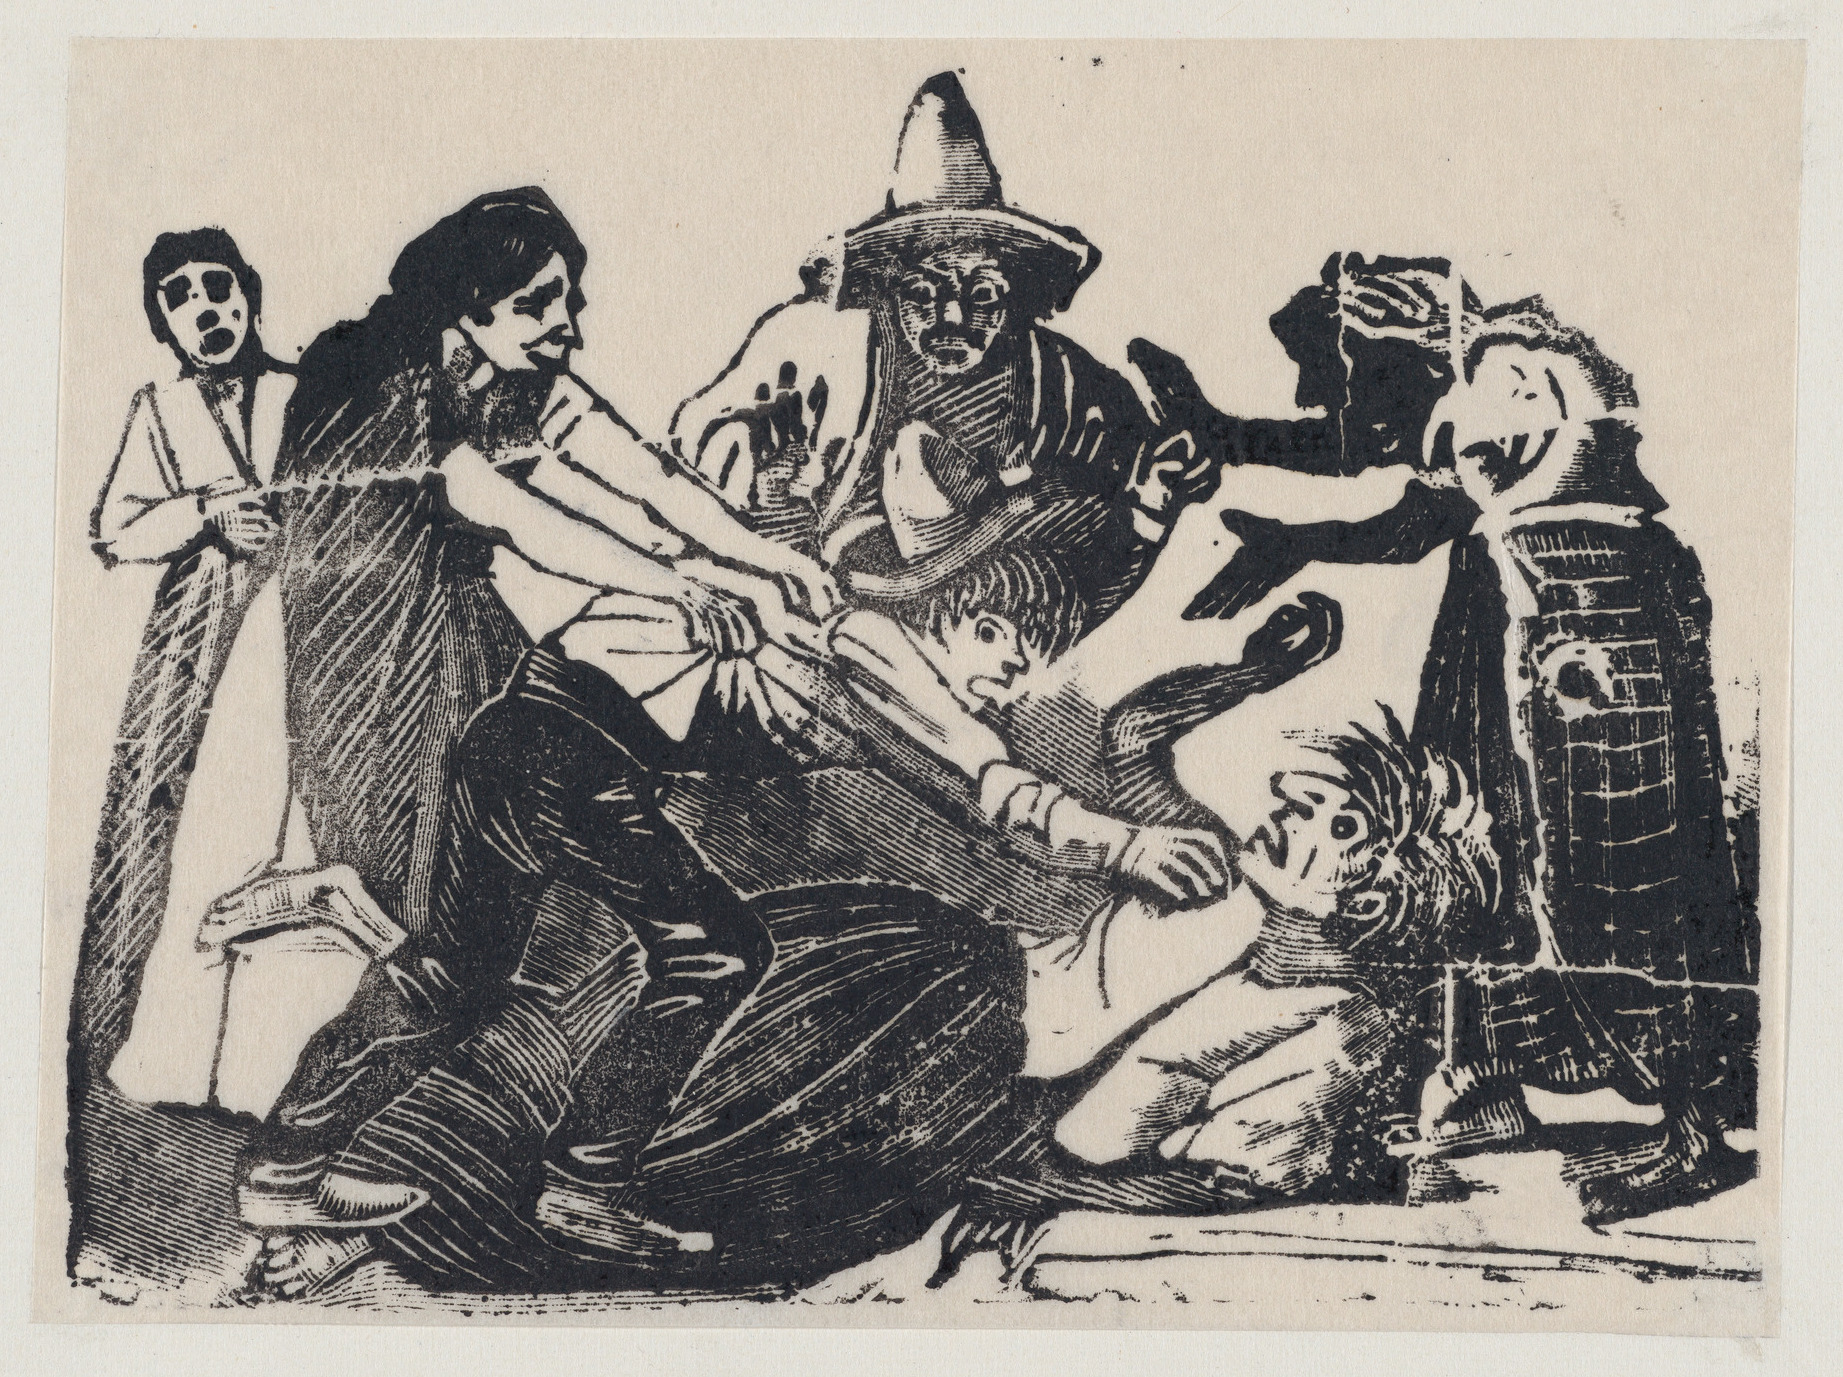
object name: print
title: A son strangling his mother while people try to pull him off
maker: josé guadalupe posada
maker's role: artist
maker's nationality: mexican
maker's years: 1852-1913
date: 1880-1910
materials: metal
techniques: engraving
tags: men,mothers